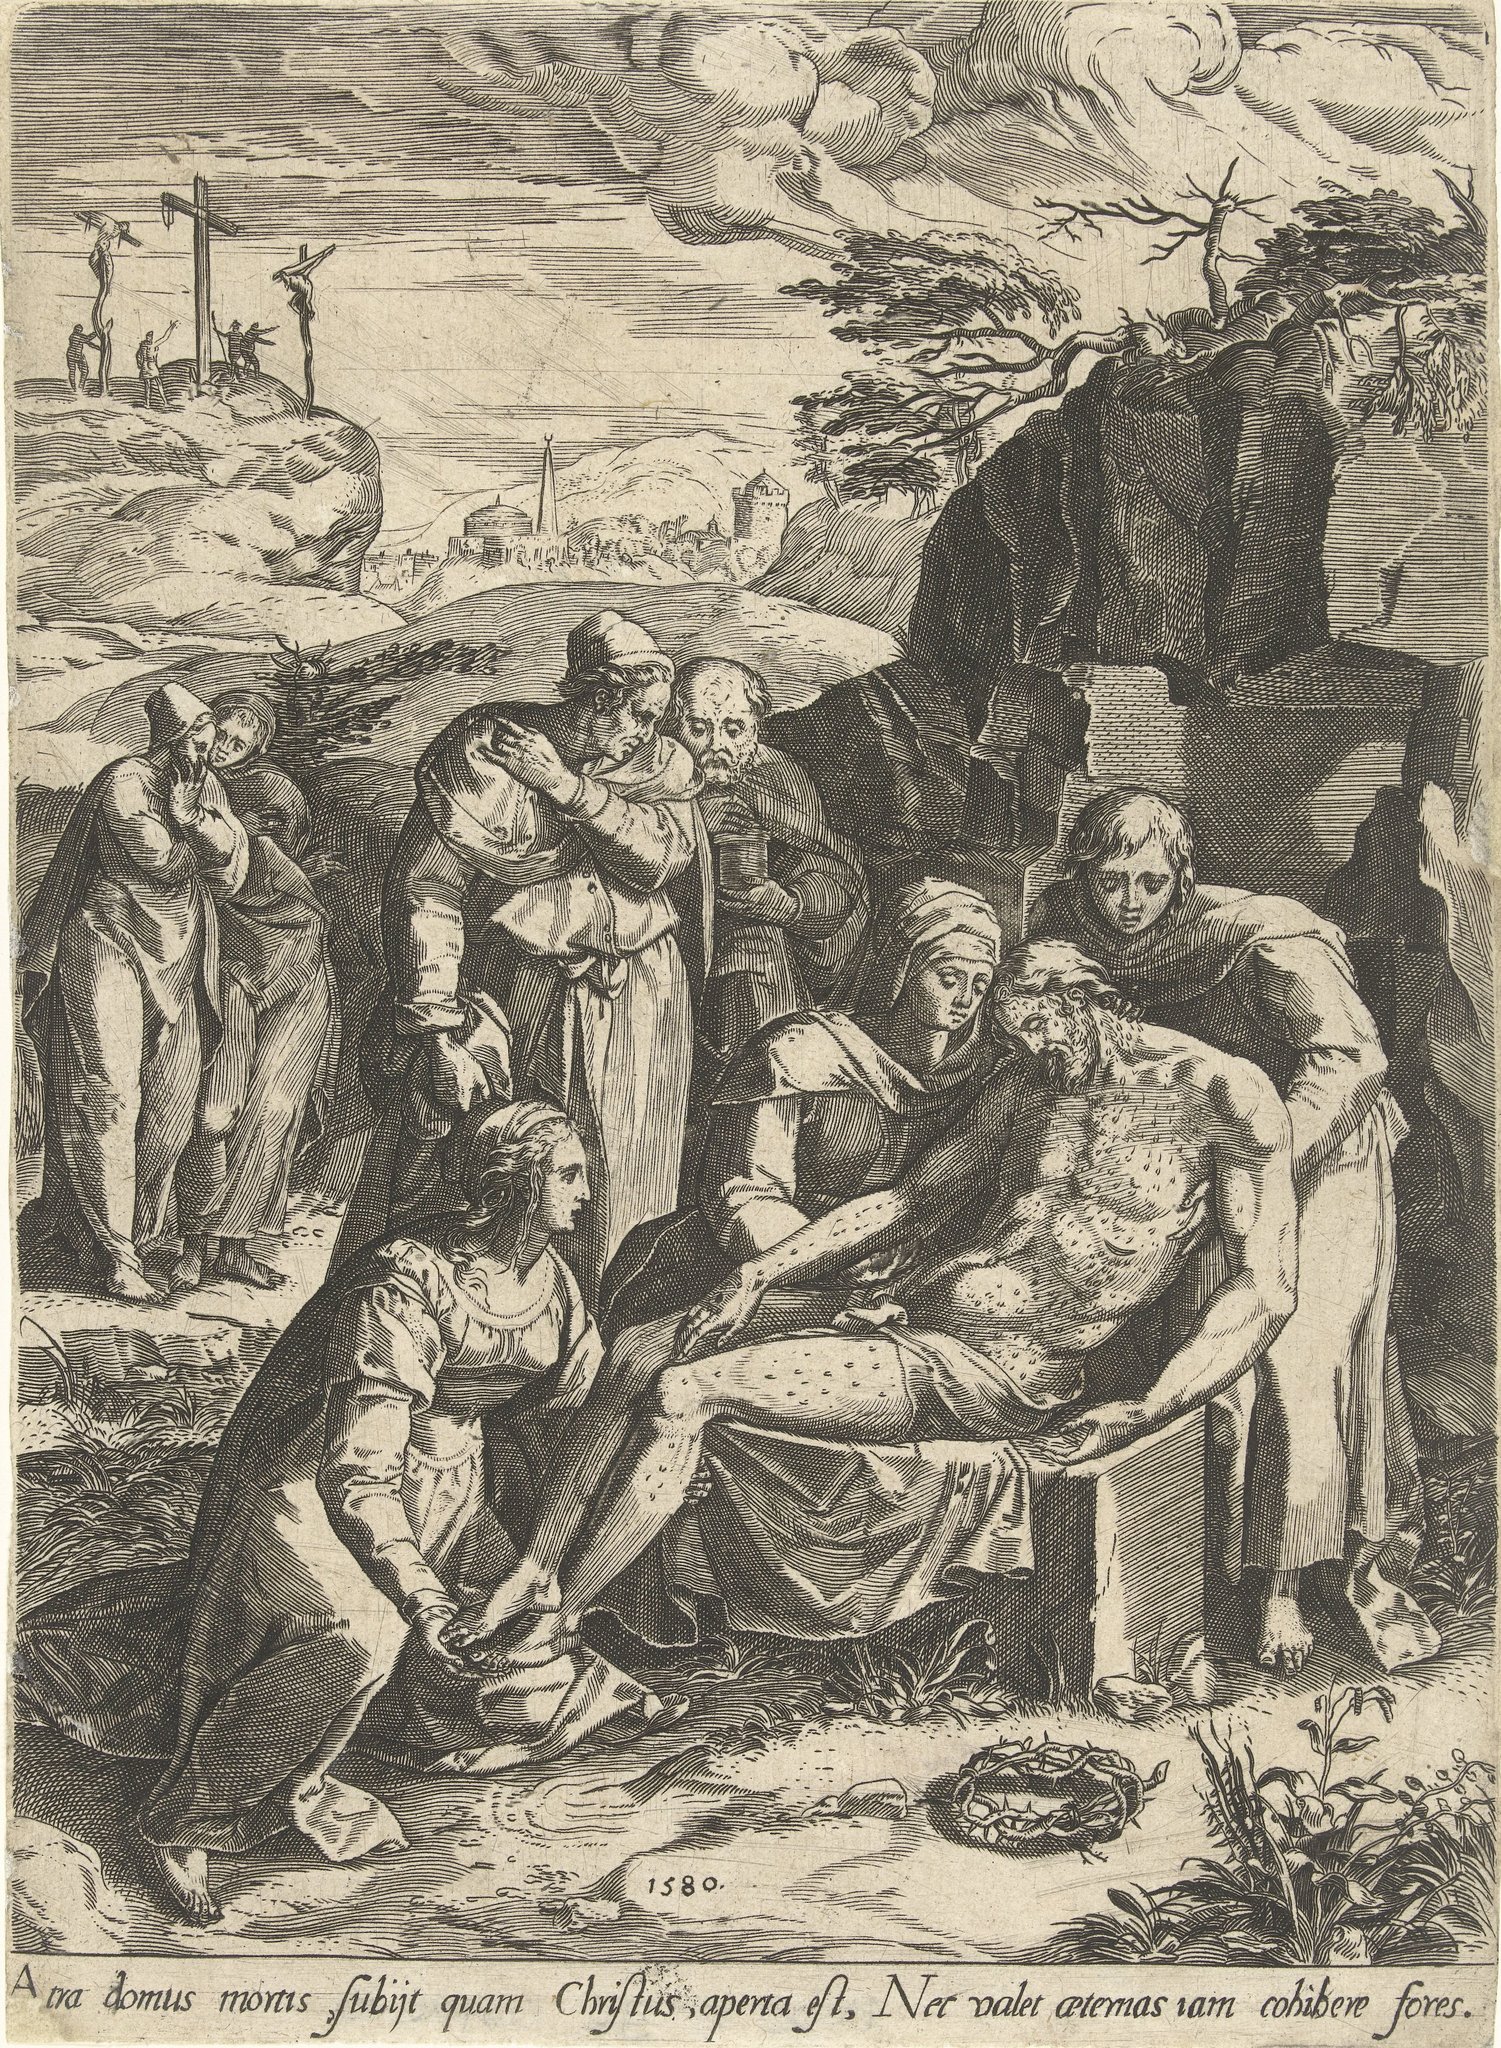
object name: print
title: Graflegging van Christus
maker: Anonymous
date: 1580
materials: paper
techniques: engraving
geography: rome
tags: christ's entombment (possibly by angels)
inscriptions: date: ‘1580’, caption: ‘Atra domus mortis...iam cohibere fores.’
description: Voor de opening in een rots ligt het lichaam van Christus op een steen, ondersteund door Maria en Johannes. Maria Magdalena knielt bij zijn voeten. Jozef van Arimatea en Nicodemus staan iets achter hen. Op de achtergrond een heuvelachtig landschap met links de berg van Golgotha.